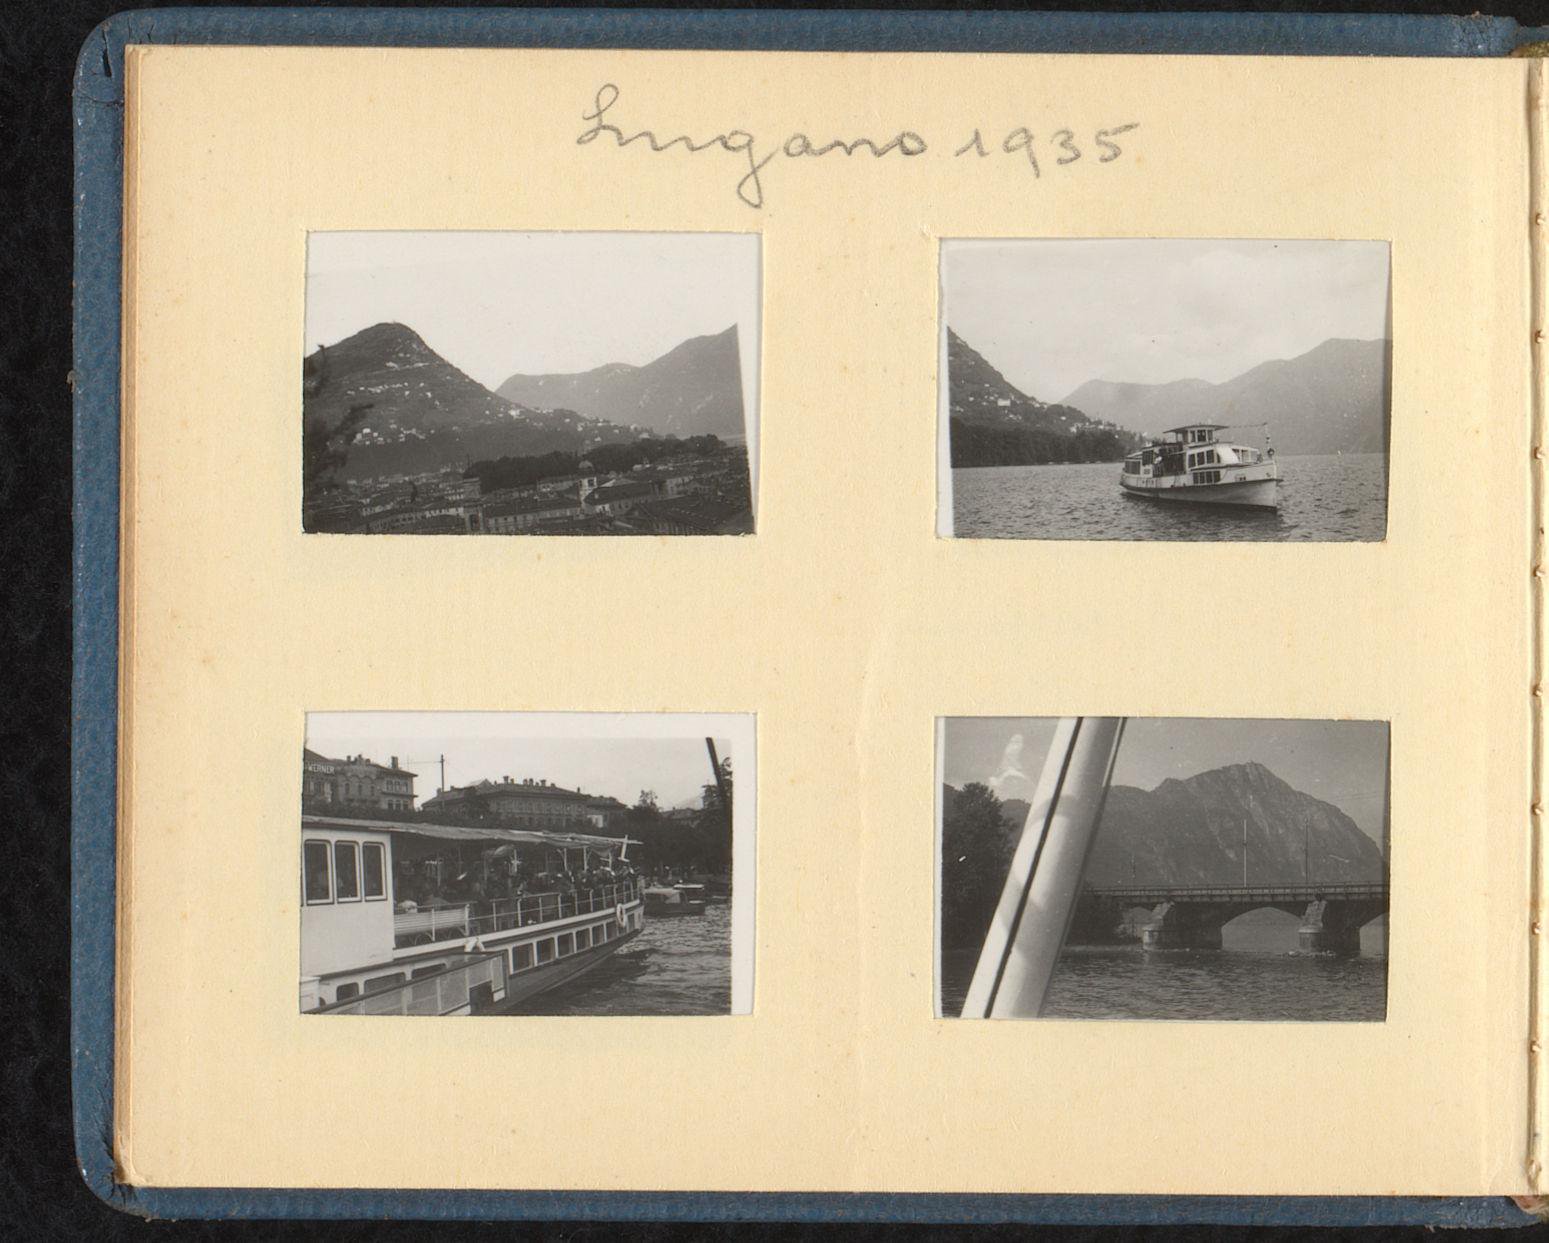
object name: photograph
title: Het meer van Lugano tijdens een vakantie van de familie Wachenheimer, zonder personen afgebeeld, 1935, Lugano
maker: else wachenheimer-moos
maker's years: 1895-1944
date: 1935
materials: paper, photographic support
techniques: gelatin silver print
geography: lugano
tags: the family travelling, on holiday, mountain-range, snow peaks, steamship, motorship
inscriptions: inscription: ‘Lugano 1935’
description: Albumblad bevat vier foto's. Zonder personen gerelateerd aan de familie Wachenheimer. Uit klein formaat fotoalbum, blauw lederen omslag met drukknopsluiting. Met foto's in klein formaat.